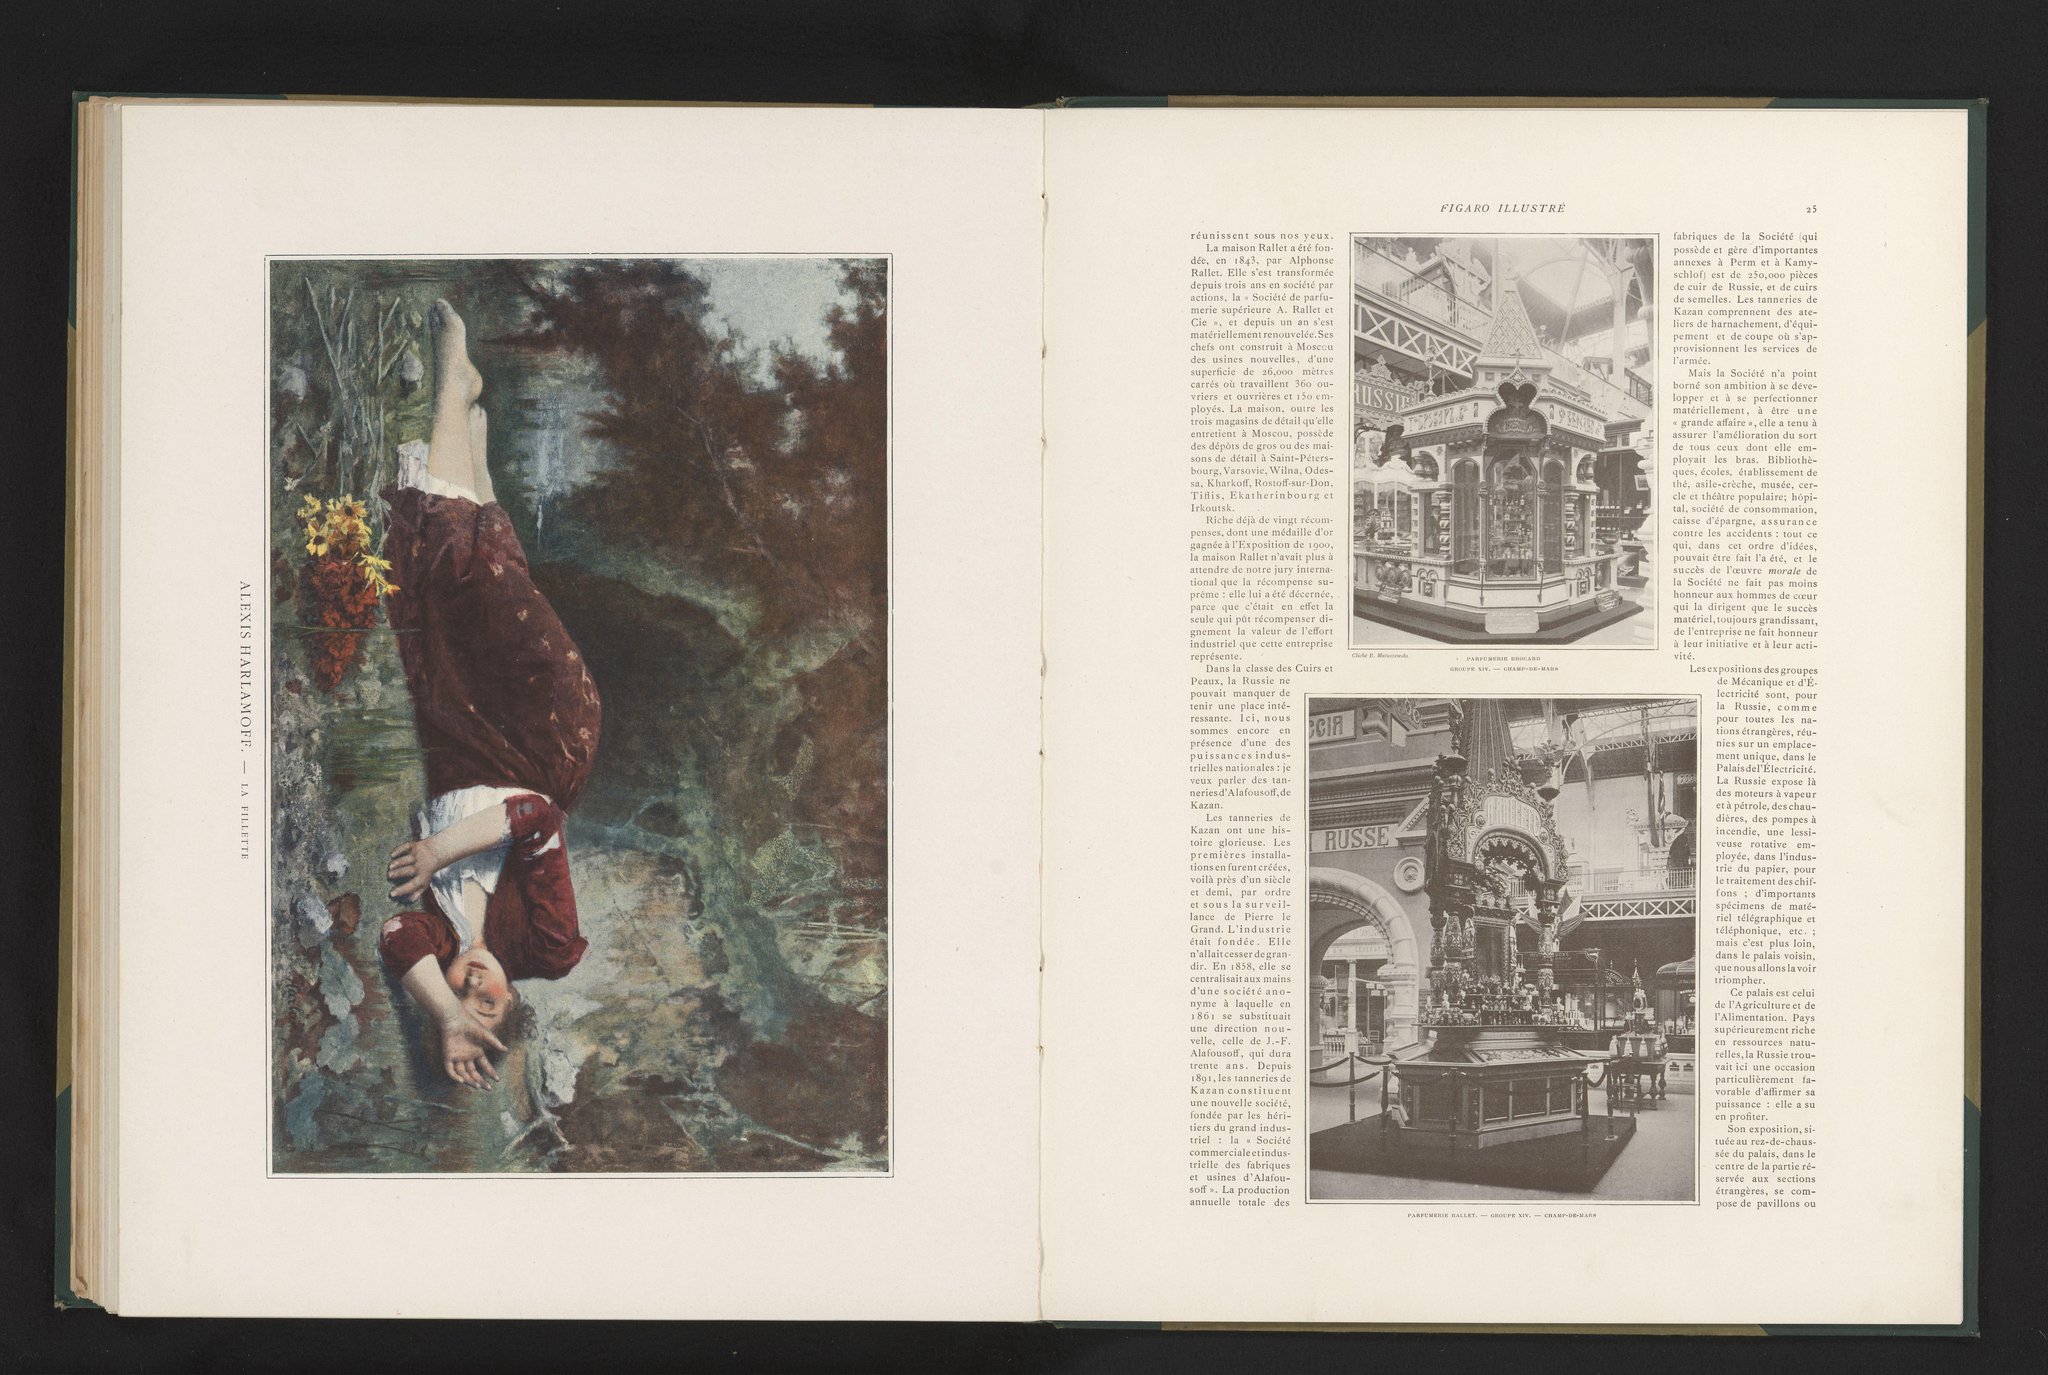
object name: page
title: La fillette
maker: Anonymous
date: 1885-1901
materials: paper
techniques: autotype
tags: cut flowers; nosegay, bunch of flowers, lying figure - aa - female human figure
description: Prent na pagina 24 van Figaro-Illustré (Décembre 1900 (2)).